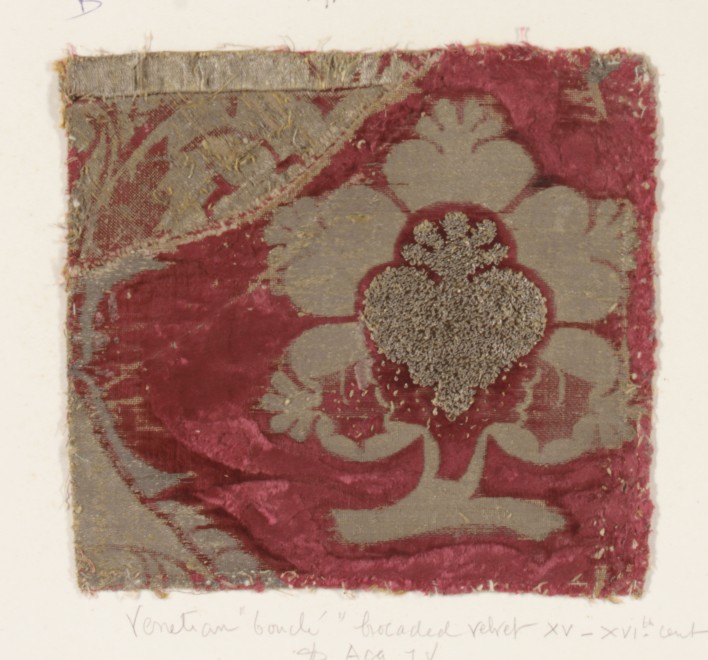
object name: fragment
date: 1401-1600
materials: metal thread, silk